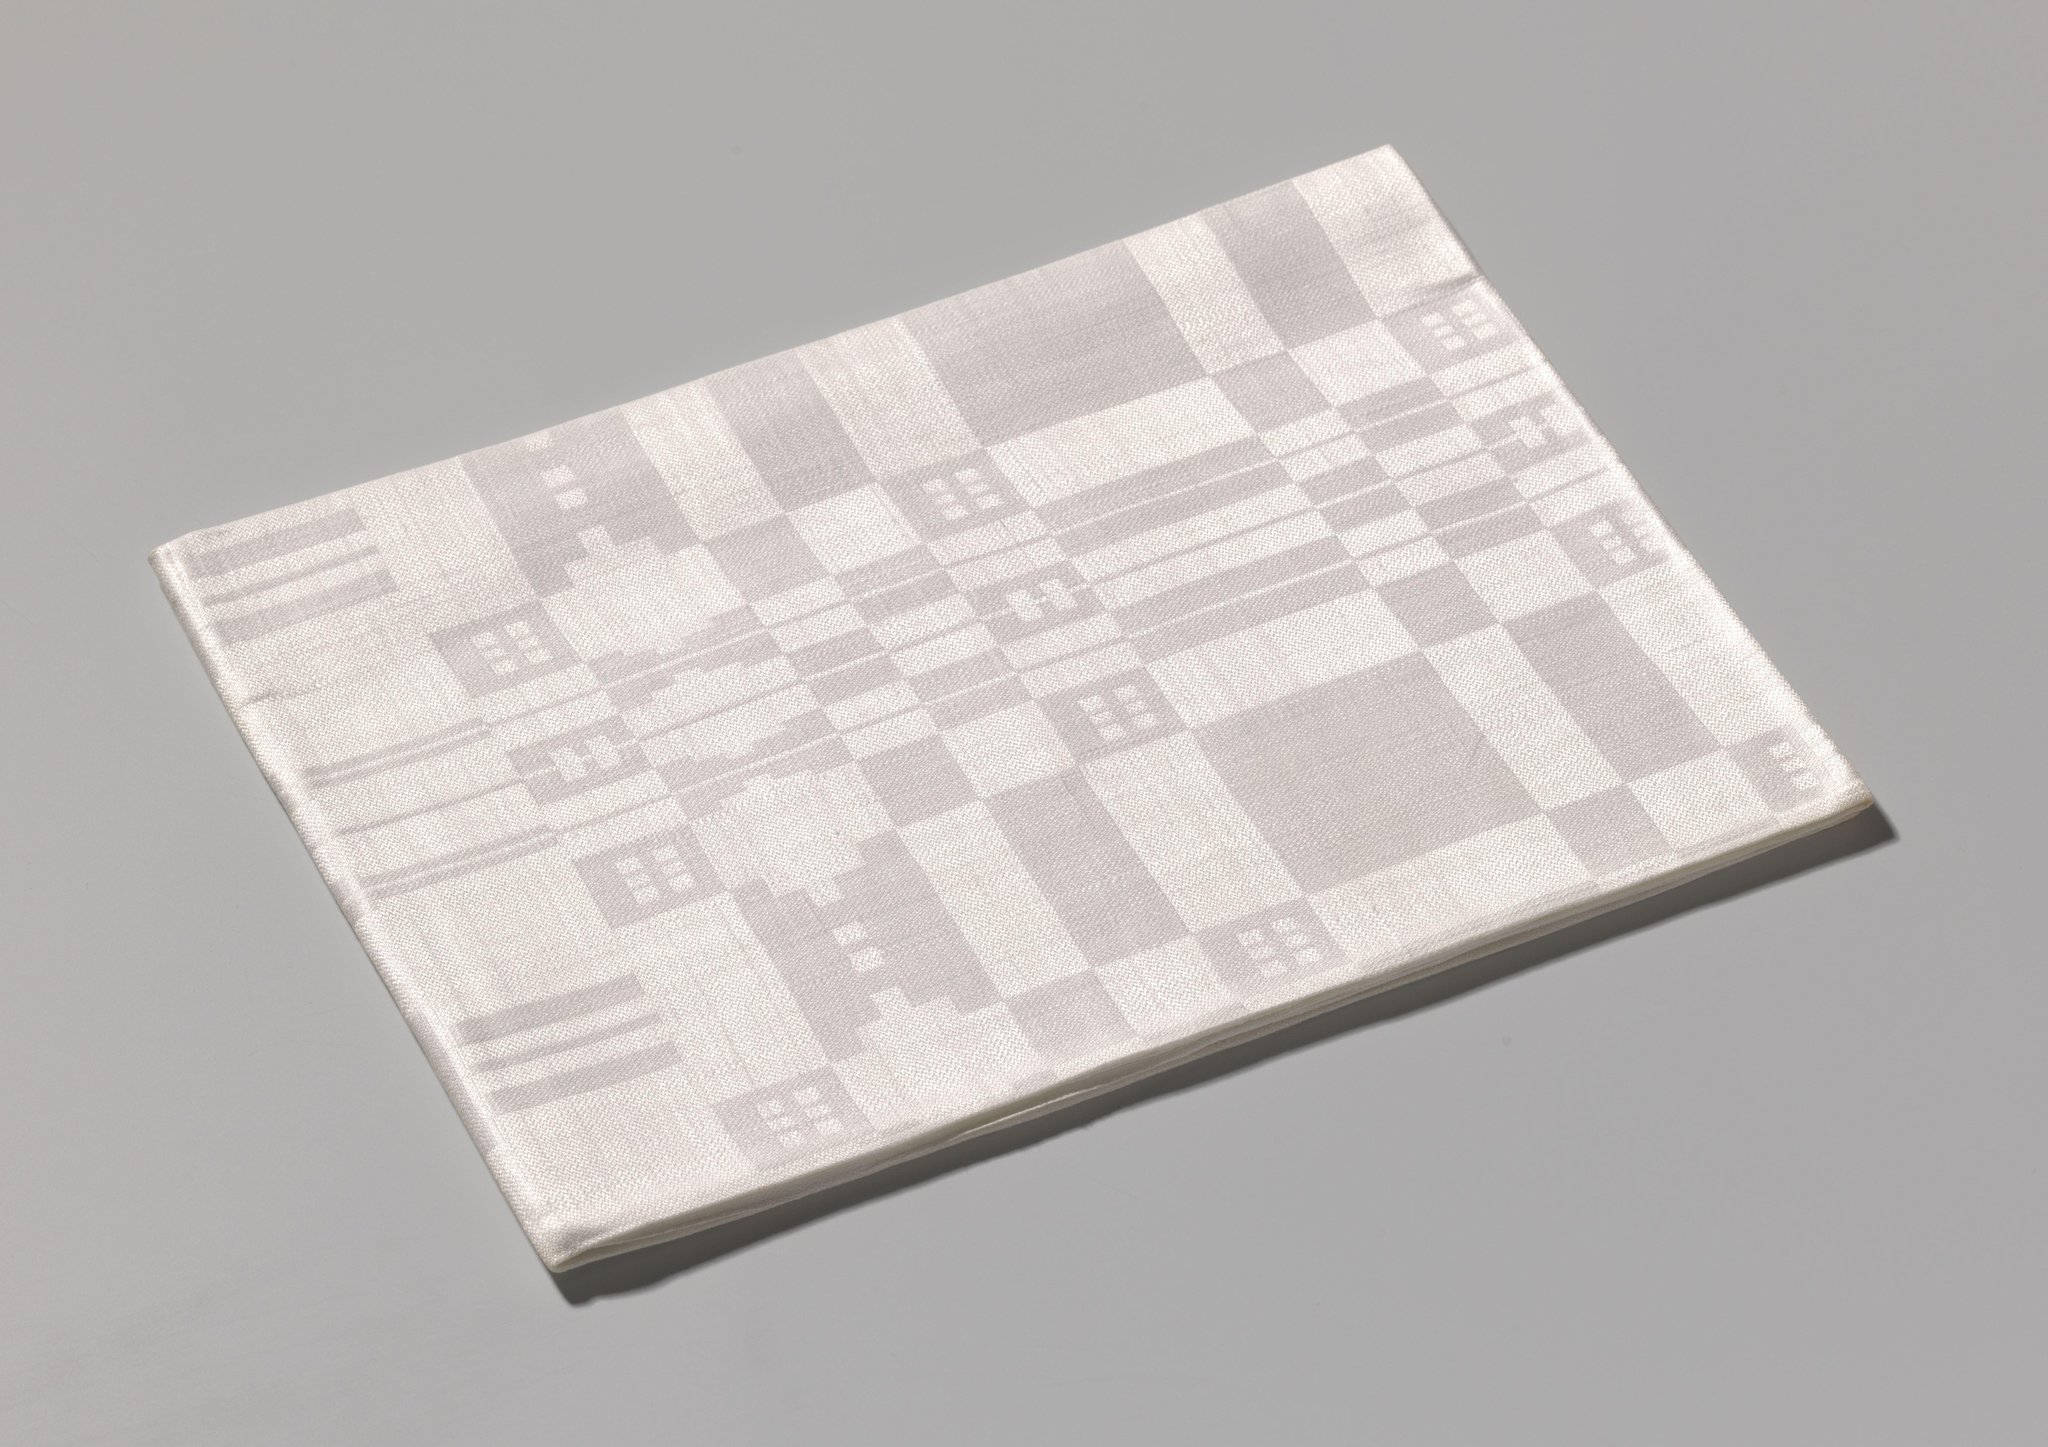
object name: napkin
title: Servet van linnen met pellenpatroon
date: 1742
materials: linen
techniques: peeled fabric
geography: northern netherlands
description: Wit linnendamasten servet met pellenpatroon, genaamd "Torenwerk". Merk kroon WG 44 1742.